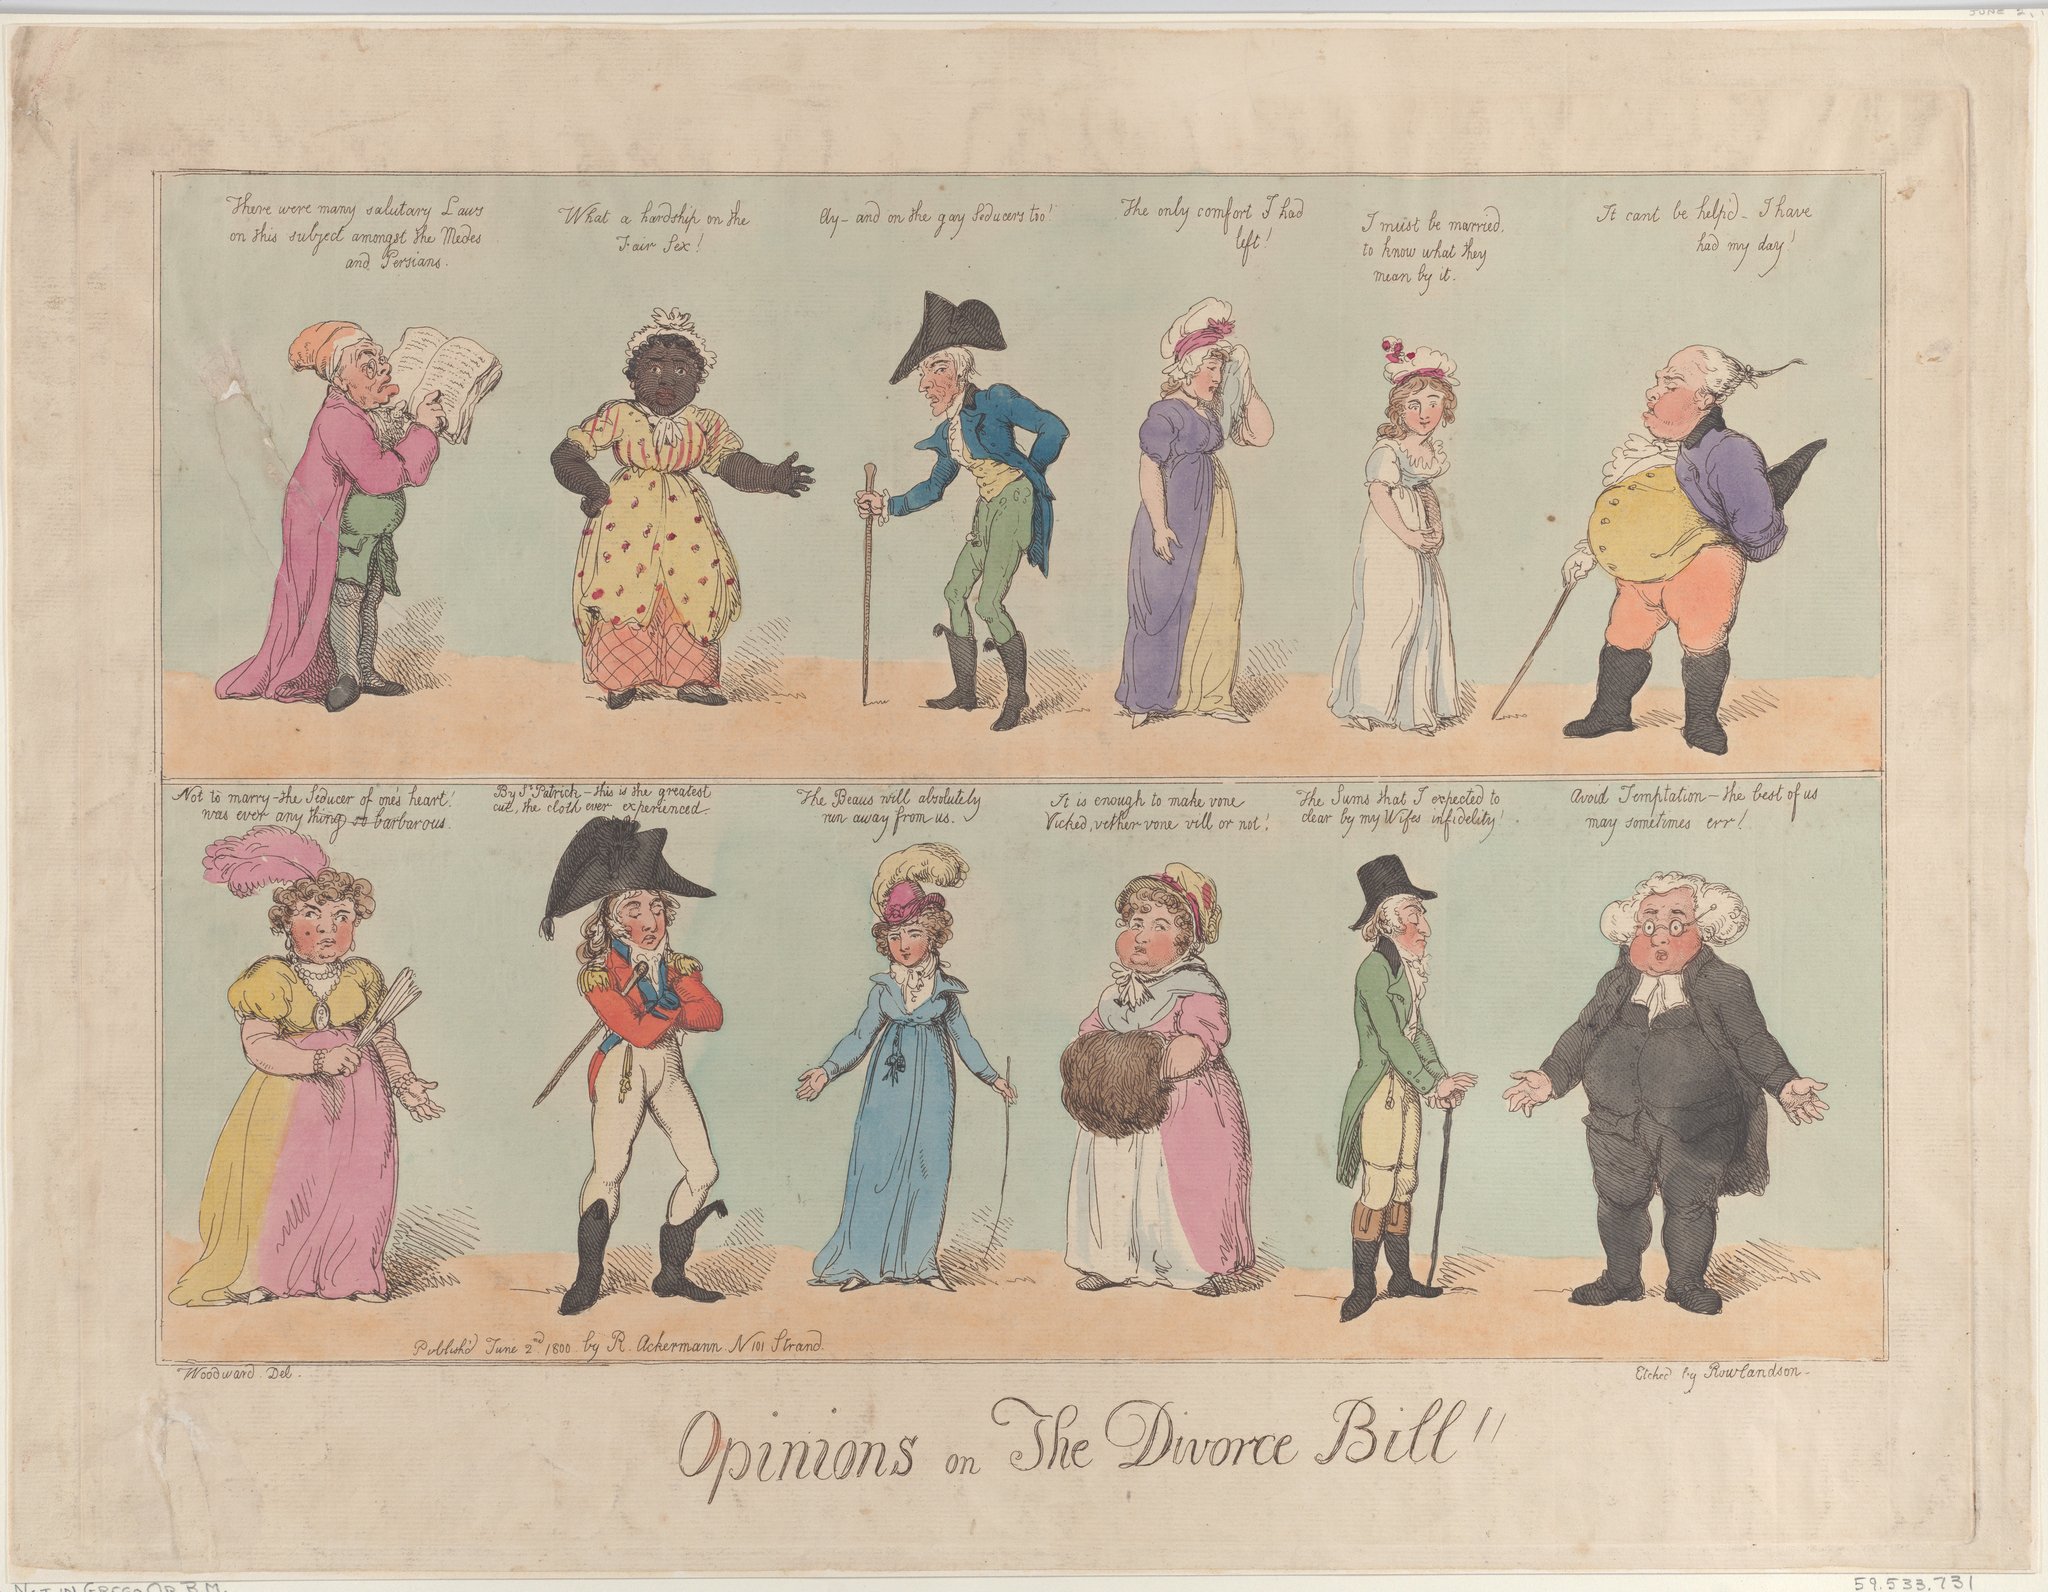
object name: print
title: Opinions on The Divorce Bill!!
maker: thomas rowlandson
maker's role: artist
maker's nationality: british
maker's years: 1757-1827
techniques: etching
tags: satire,men,women